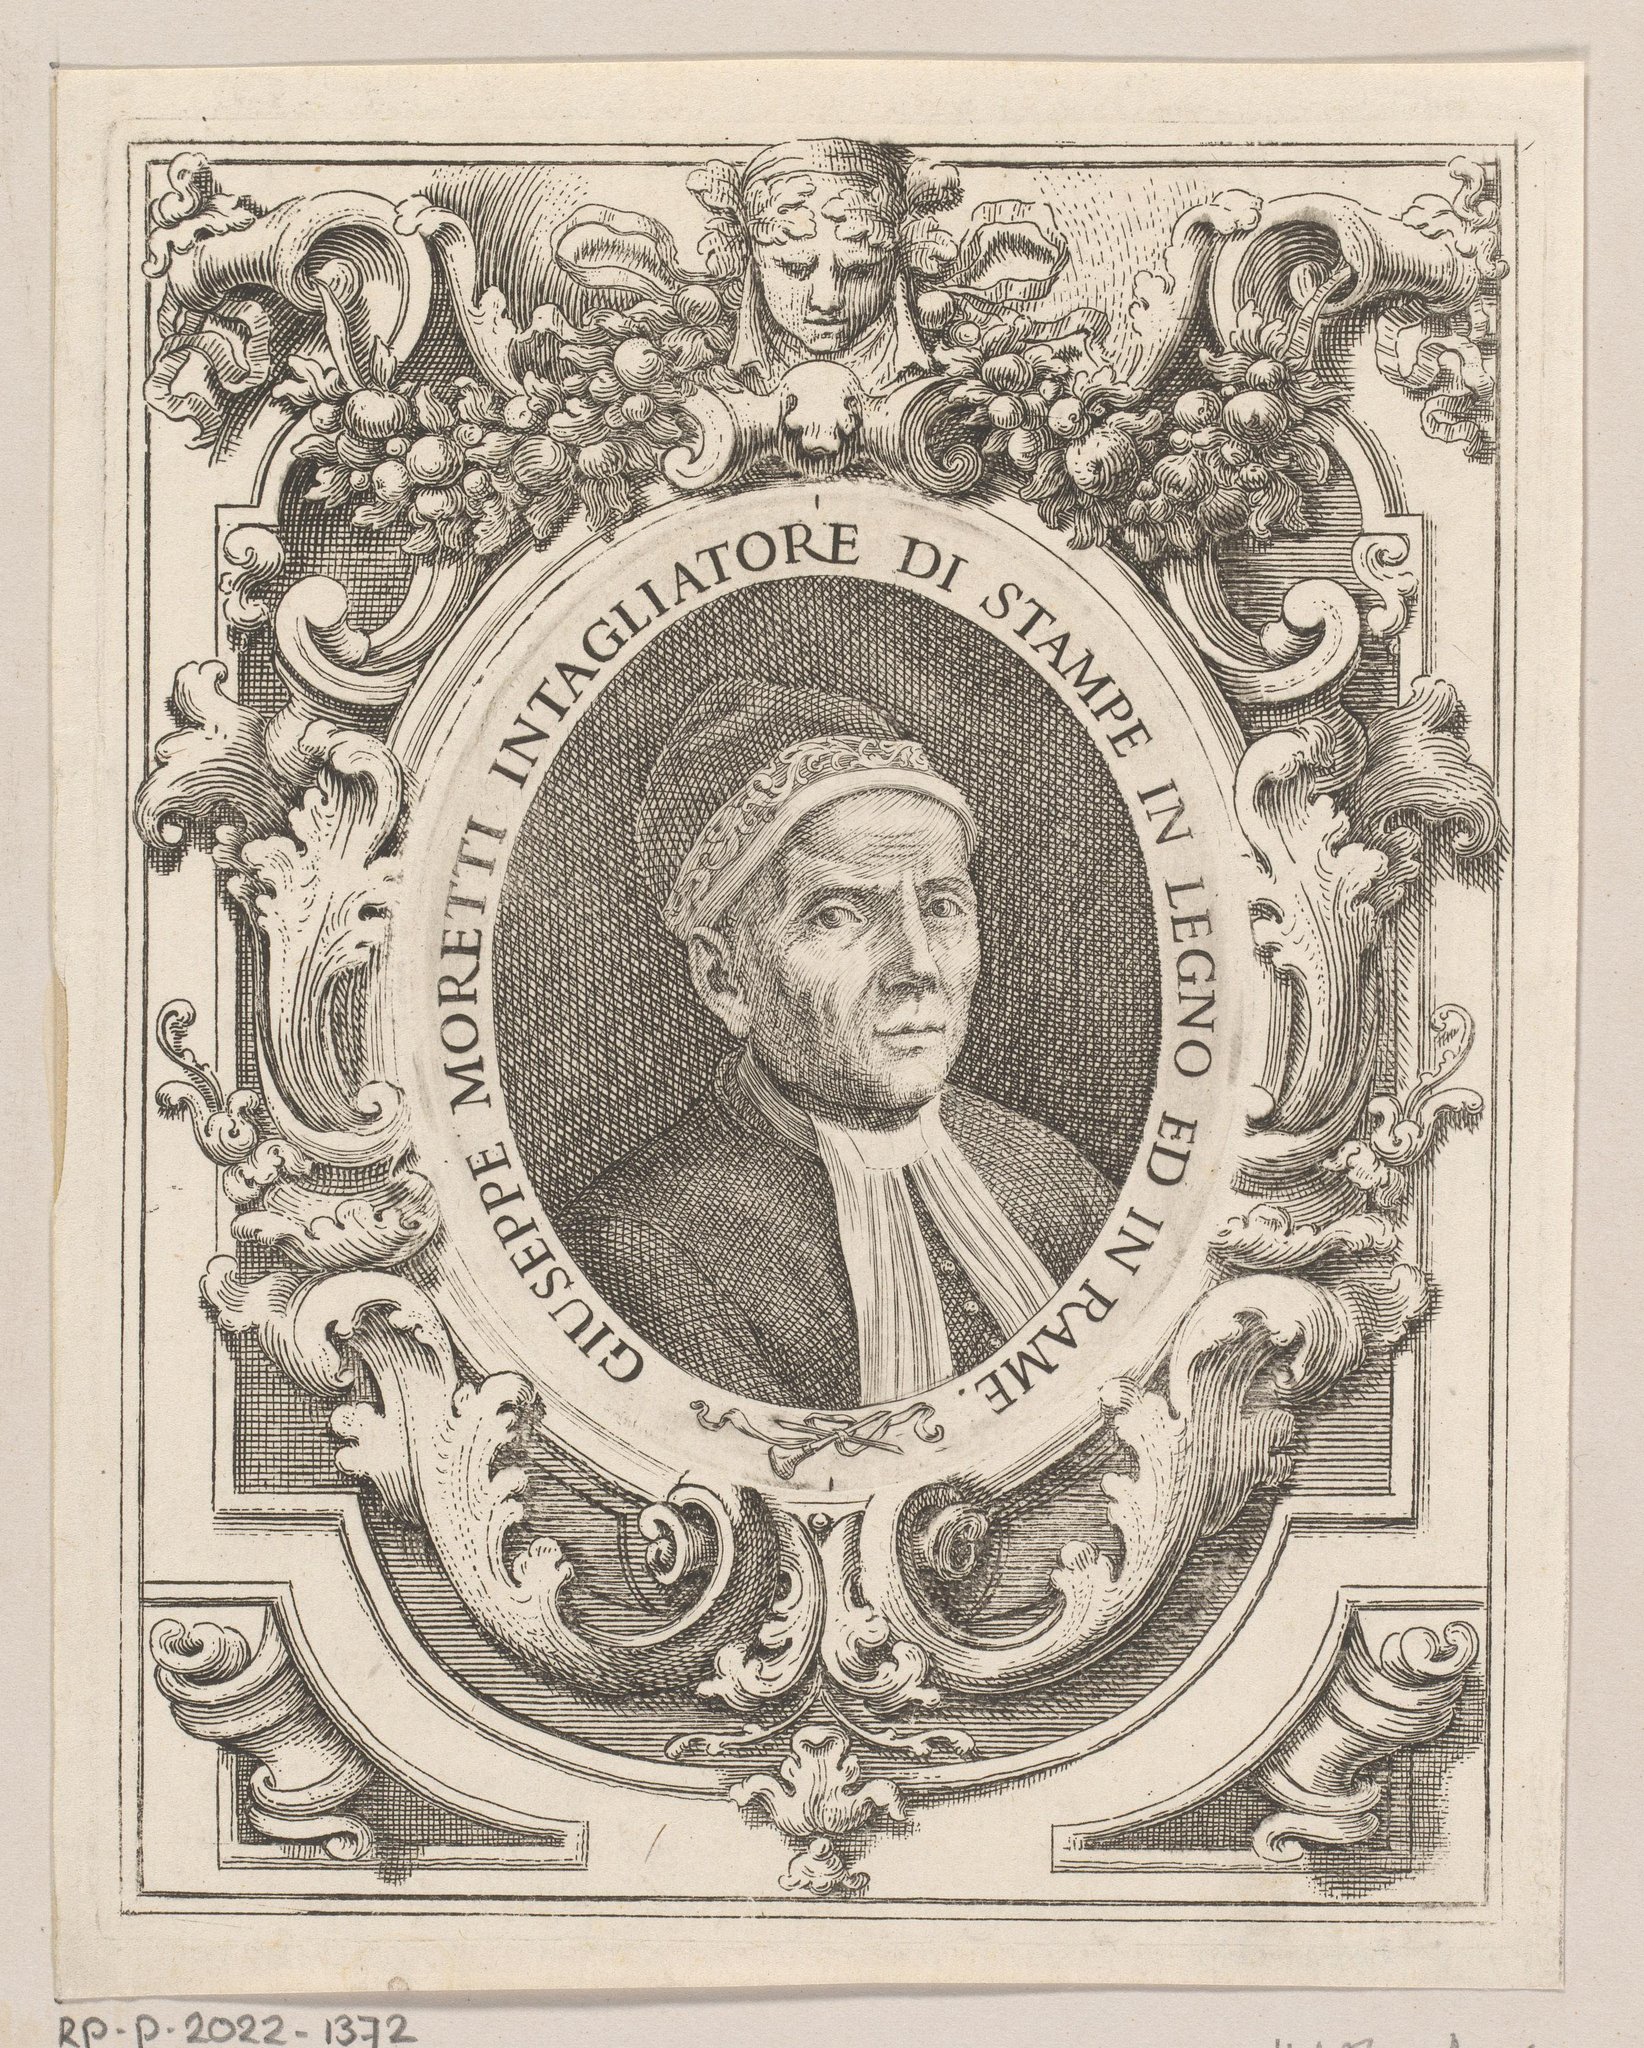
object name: print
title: Giuseppe Moretti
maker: Anonymous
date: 1675-1800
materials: paper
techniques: engraving, etching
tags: print maker, giuseppe maria moretti, historical persons, portrait, self-portrait of graphic artist